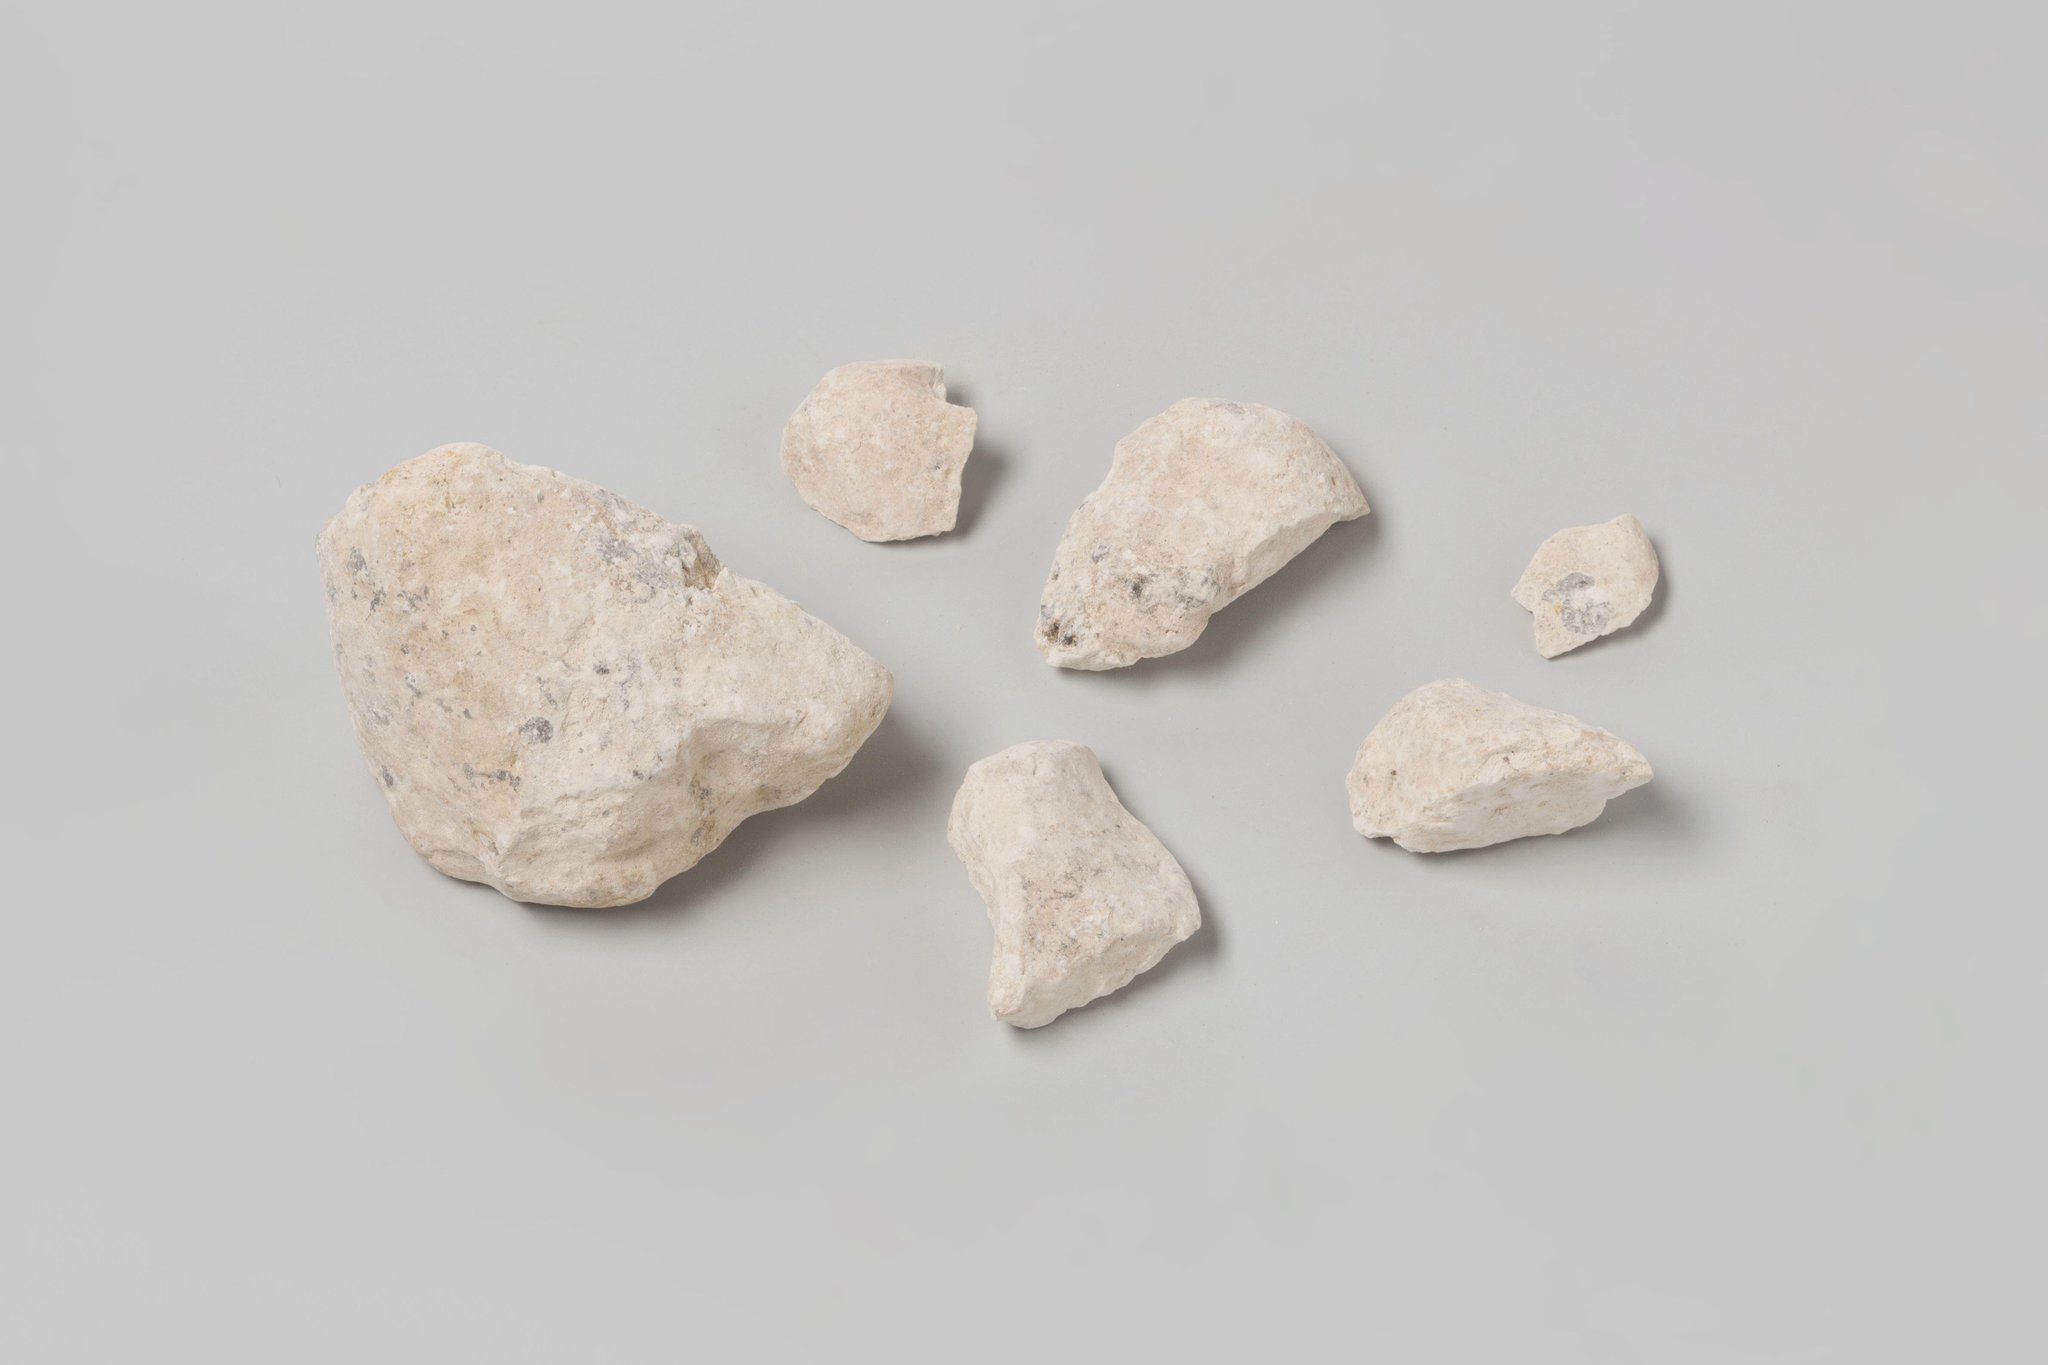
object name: scheepswrakvondst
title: Fragmenten en gruis van gips uit het wrak van de Oost-Indiëvaarder Hollandia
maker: Anonymous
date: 1700-1743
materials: gypsum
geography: netherlands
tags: verenigde oostindische compagnie, hollandia (schip), annet